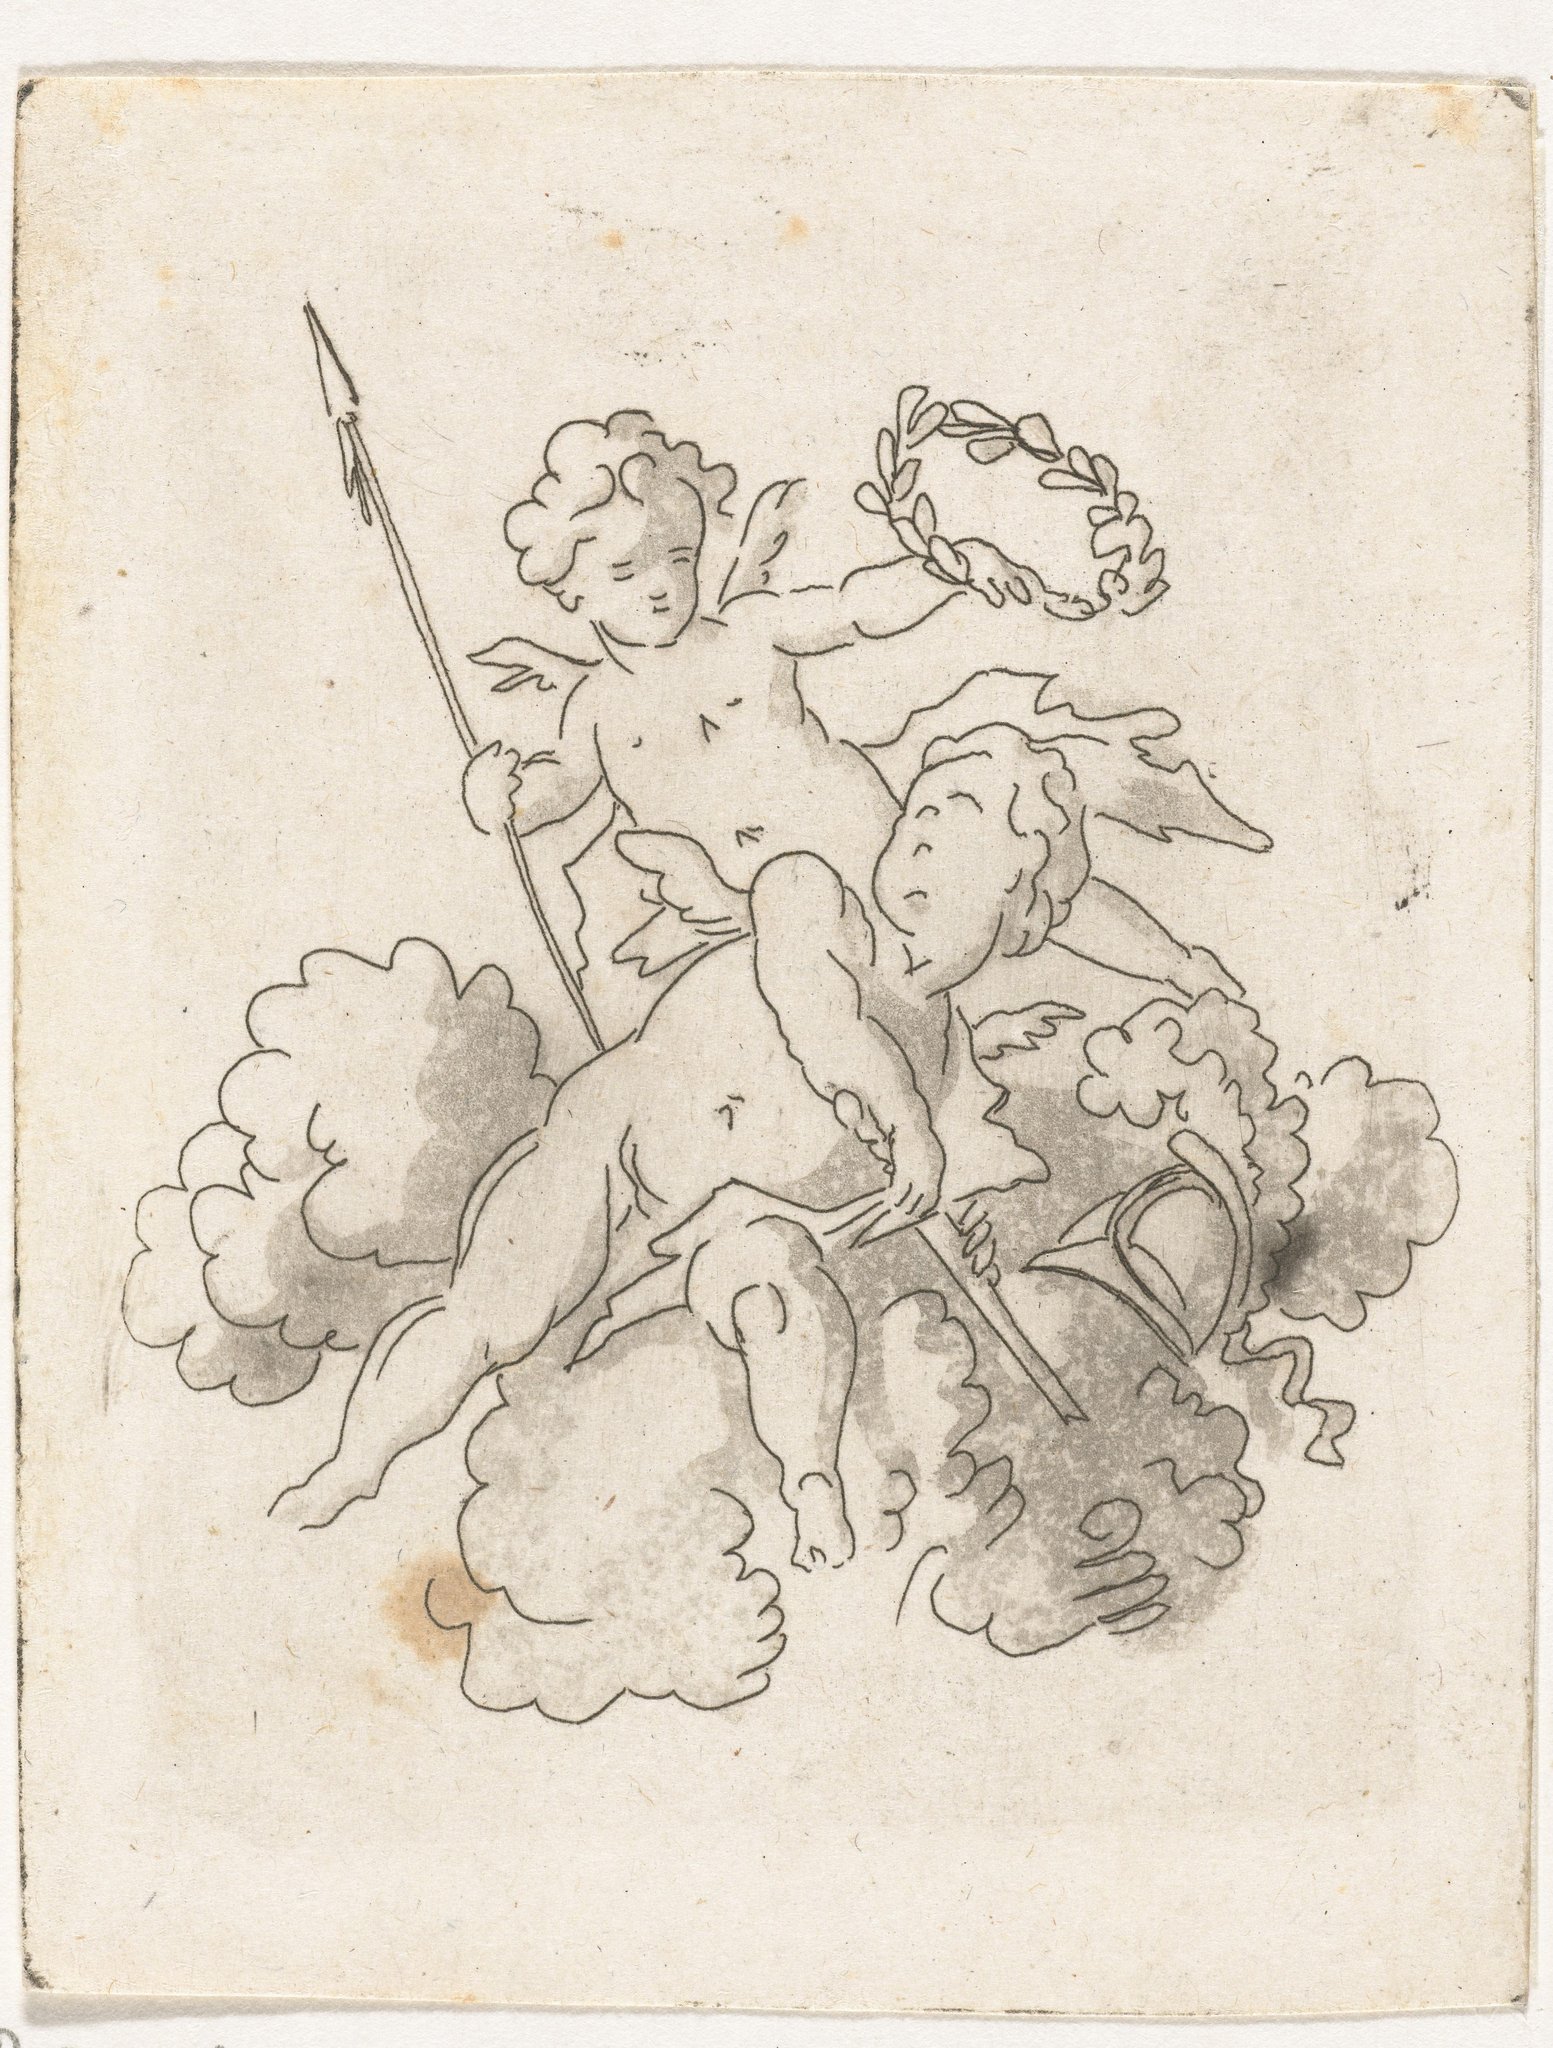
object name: print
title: Twee putti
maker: anthonie van den bos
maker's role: draughtsman, print maker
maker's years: 1763-1838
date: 1778-1838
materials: paper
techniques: aquatint, etching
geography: netherlands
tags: cupids: 'amores', 'amoretti', 'putti'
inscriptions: collector's mark: Lugt 2228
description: Een putto trekt zijn zwaard, naast hem ligt zijn helm op een wolk. Een ander putto houdt een lauwerkrans en een lans in zijn handen.